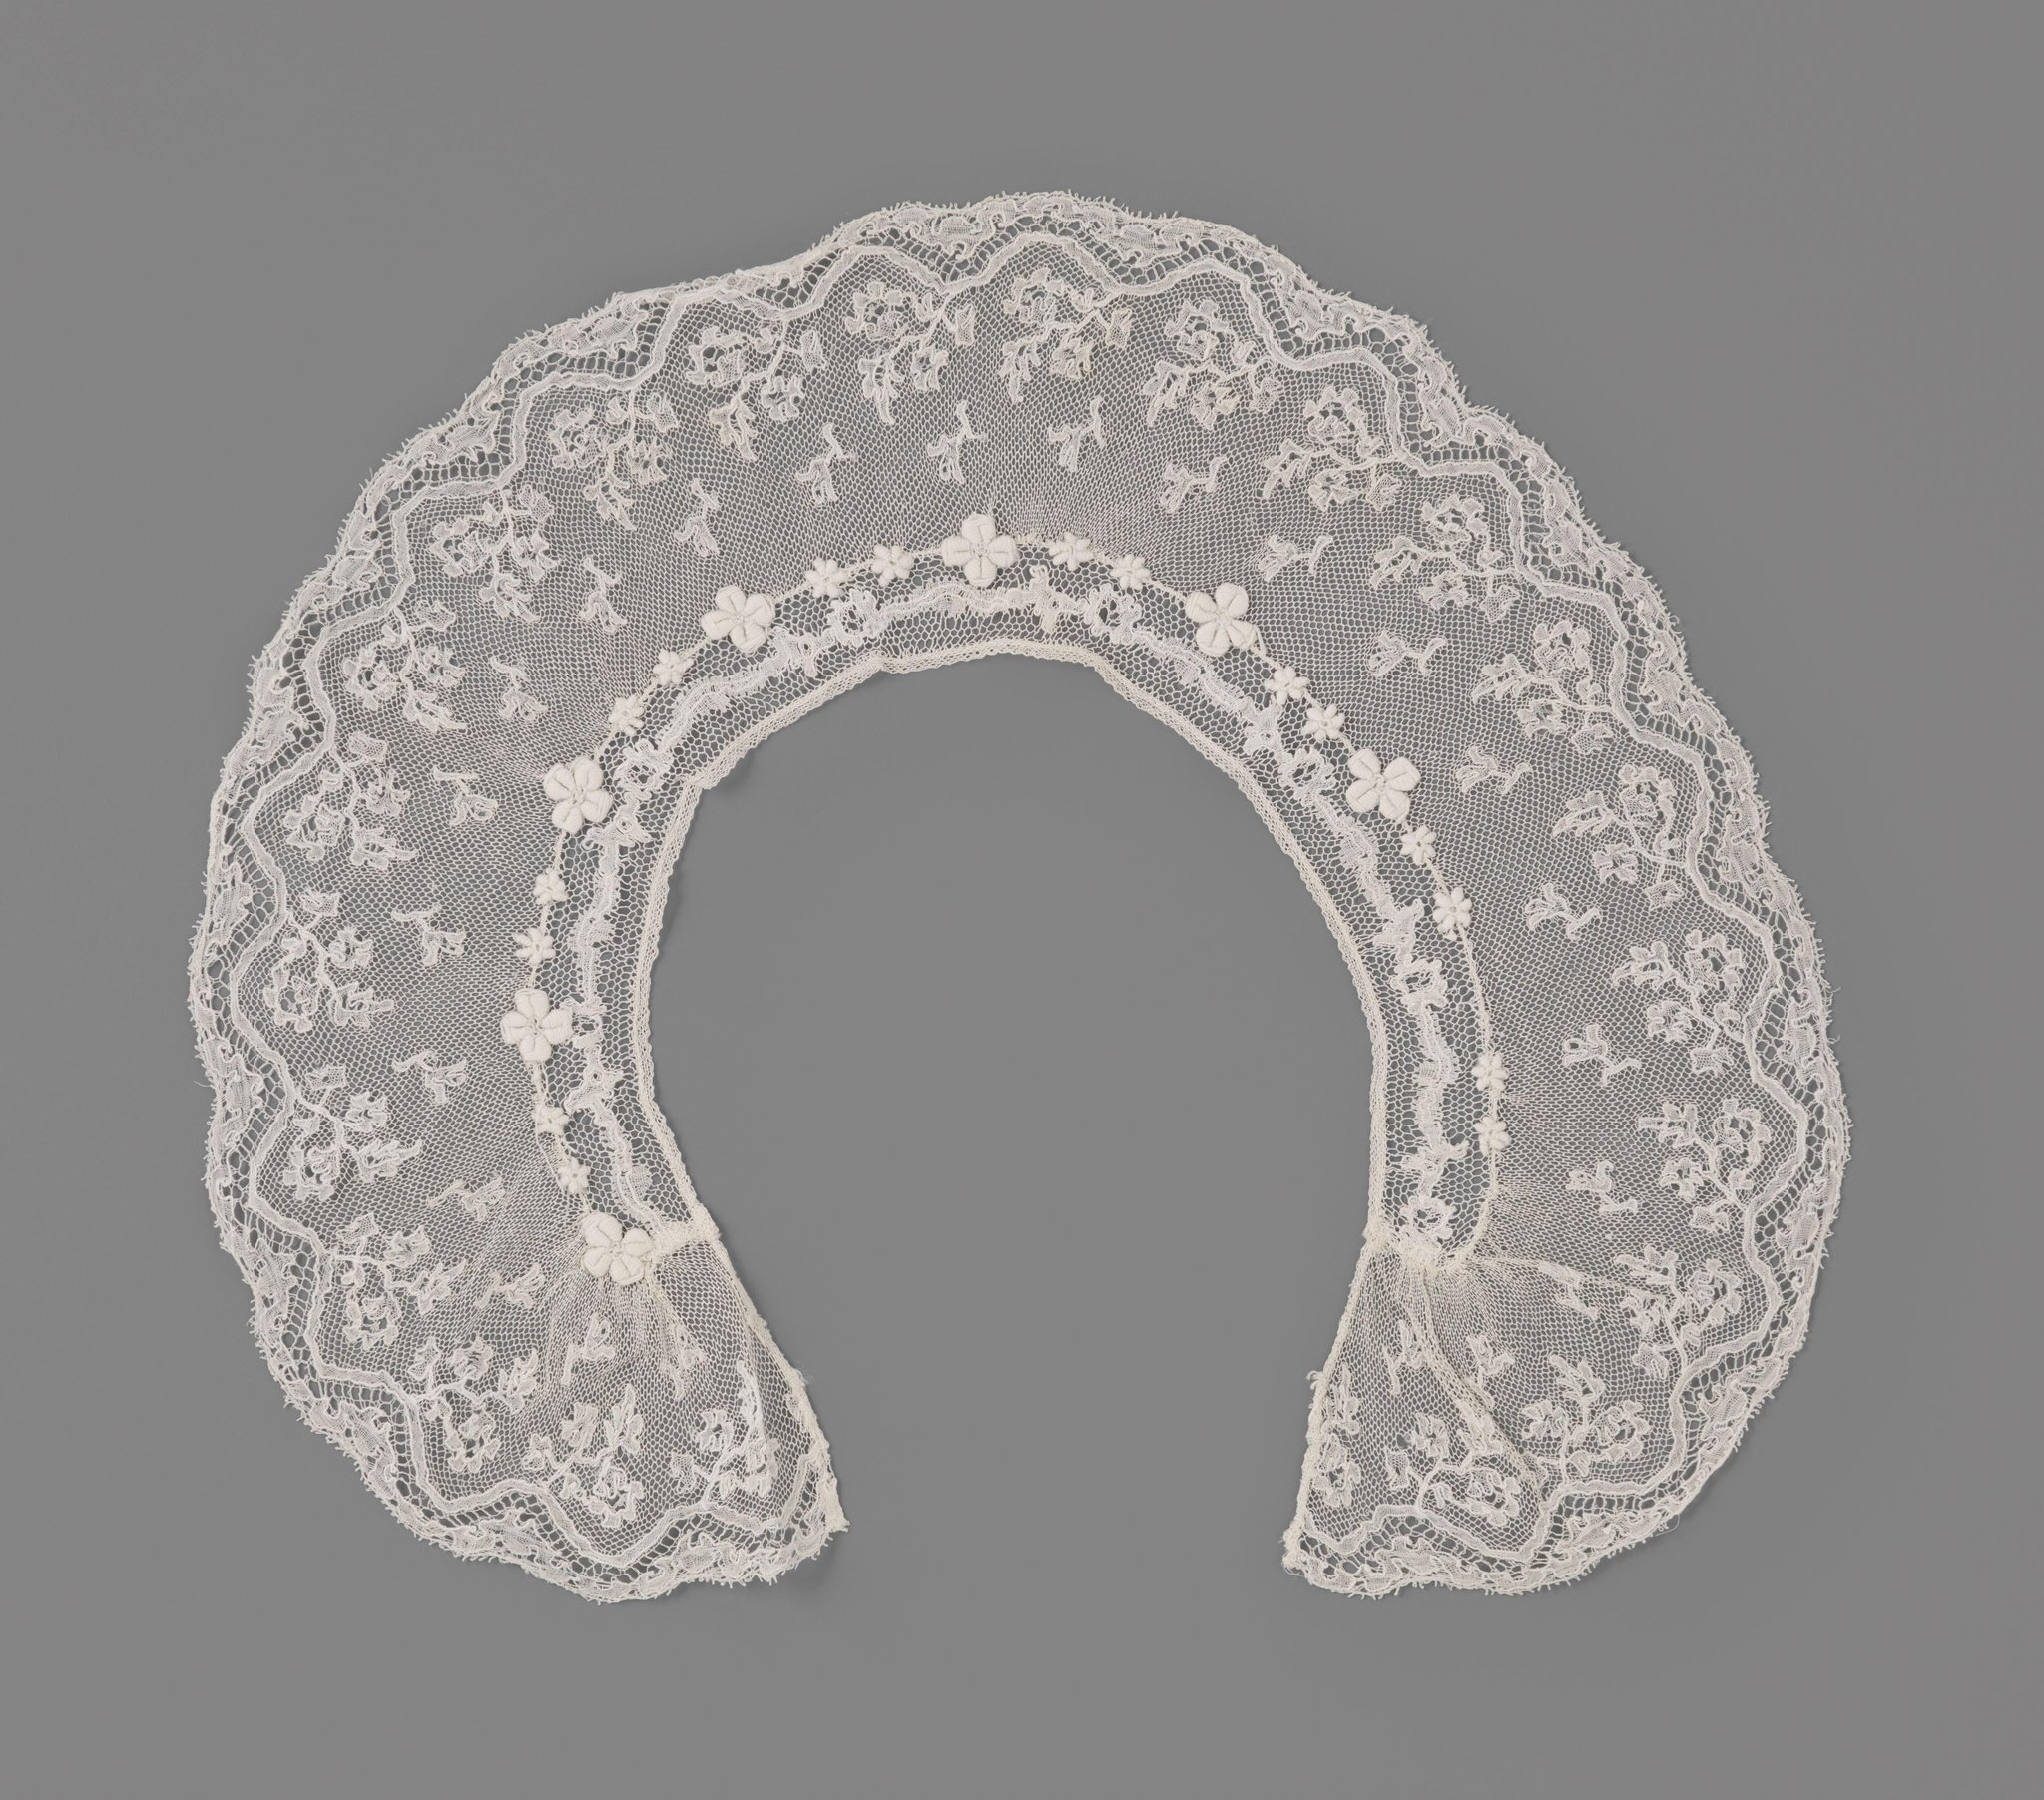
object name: collar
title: Ronde kraag van Mechelse kant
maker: Anonymous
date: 1850-1870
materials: lace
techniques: lace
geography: mechelen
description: Ronde kraag van Mechelse kant, die wellicht met een of twee andere overelkaar gedragen werd. Versierd met een hoekige berg-en-dallijn waarboven een kleine bloem in lopend patroon herhaald wordt. Op de naad is een agrement met een rozet en vergeet-mij-nietjes genaaid.